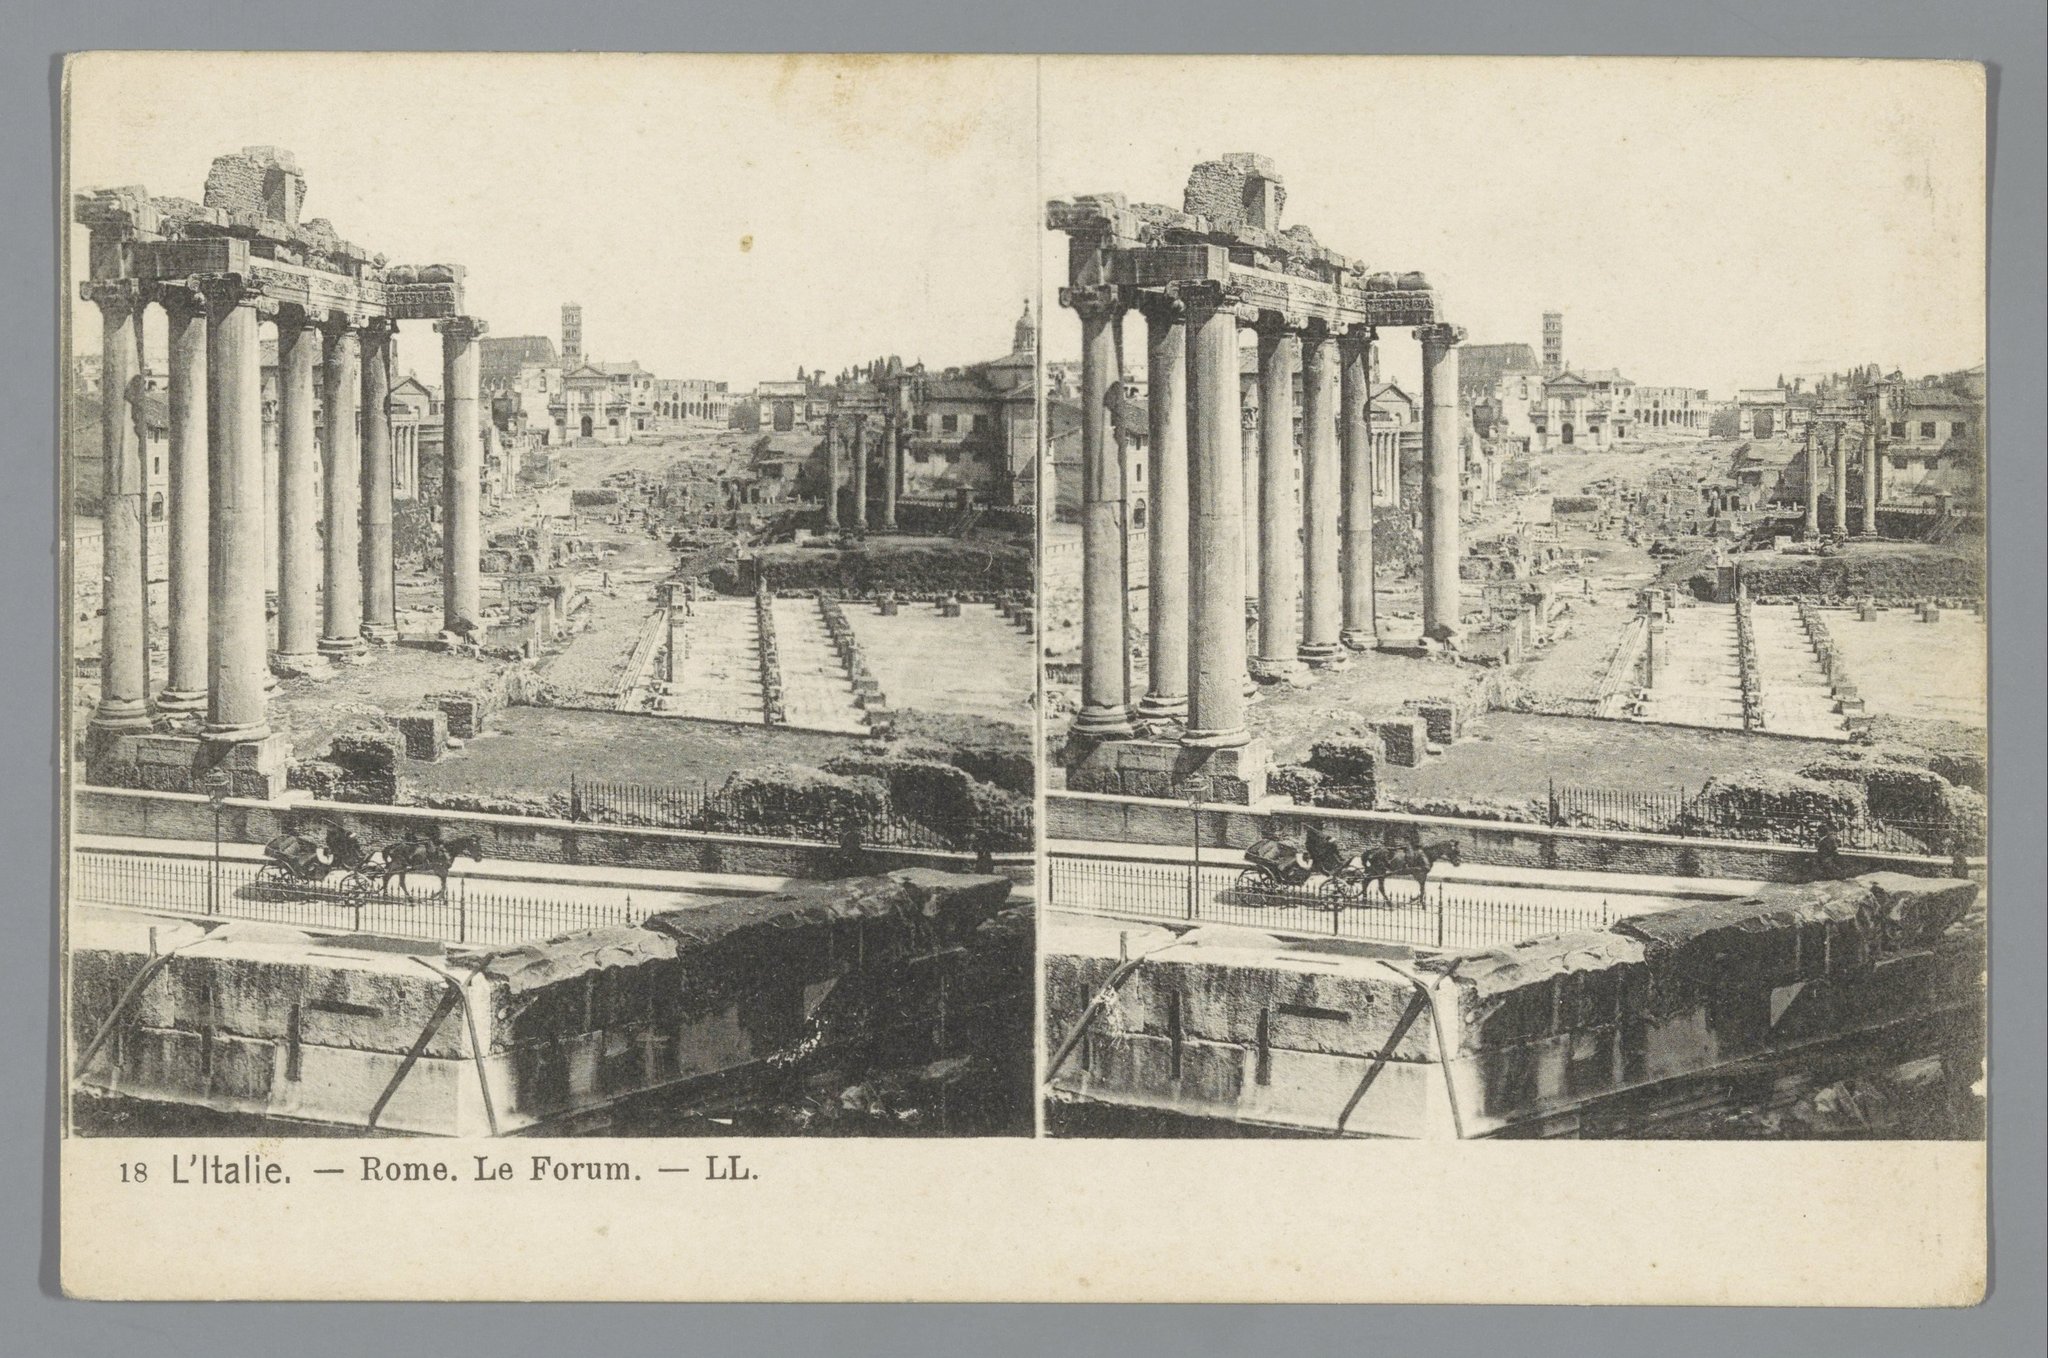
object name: stereograph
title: L'Italie. - Rome. Le Forum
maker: Anonymous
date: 1898-1920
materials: paper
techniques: photograph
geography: europe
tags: temple, shrine ~ roman religion, excavation ~ archaeology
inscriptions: number: ‘18’